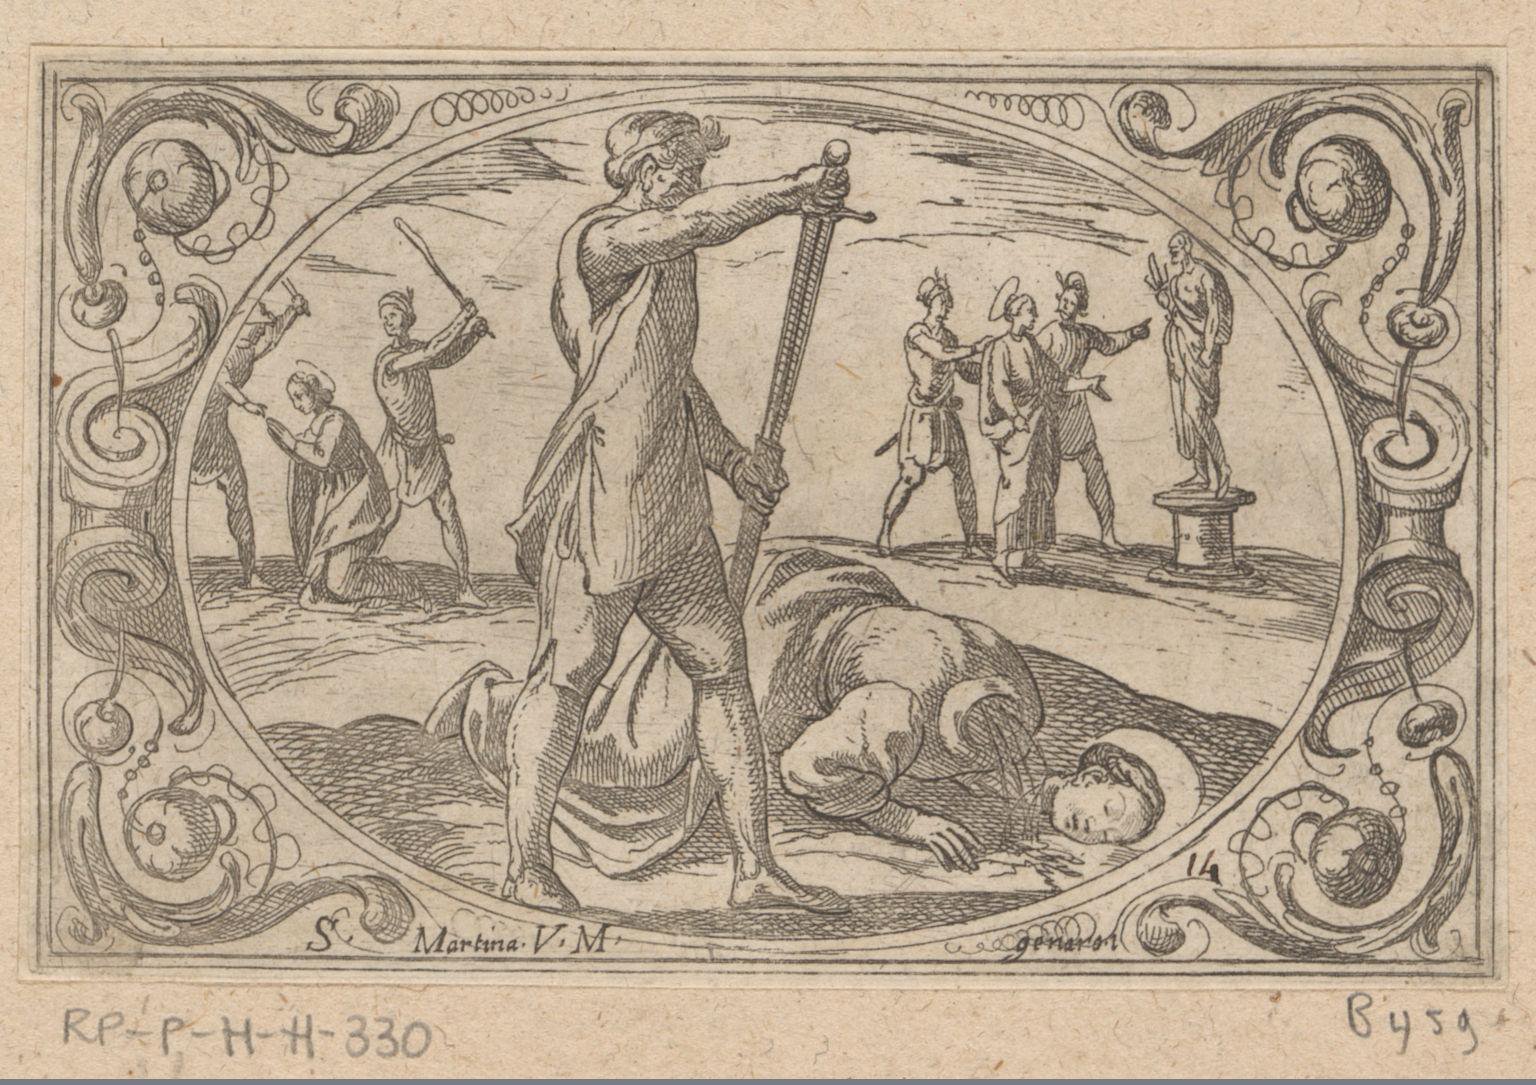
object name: print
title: H. Martina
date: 1565-1630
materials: paper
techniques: etching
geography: rome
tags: martyr(s) (often with palm-branches) - qq - female martyr, violent death by beheading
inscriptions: number: ‘14’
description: Deze prent maakt deel uit van een reeks van 73 prenten (+ titelprent) met voorstellingen van Romeinse martelaressen.